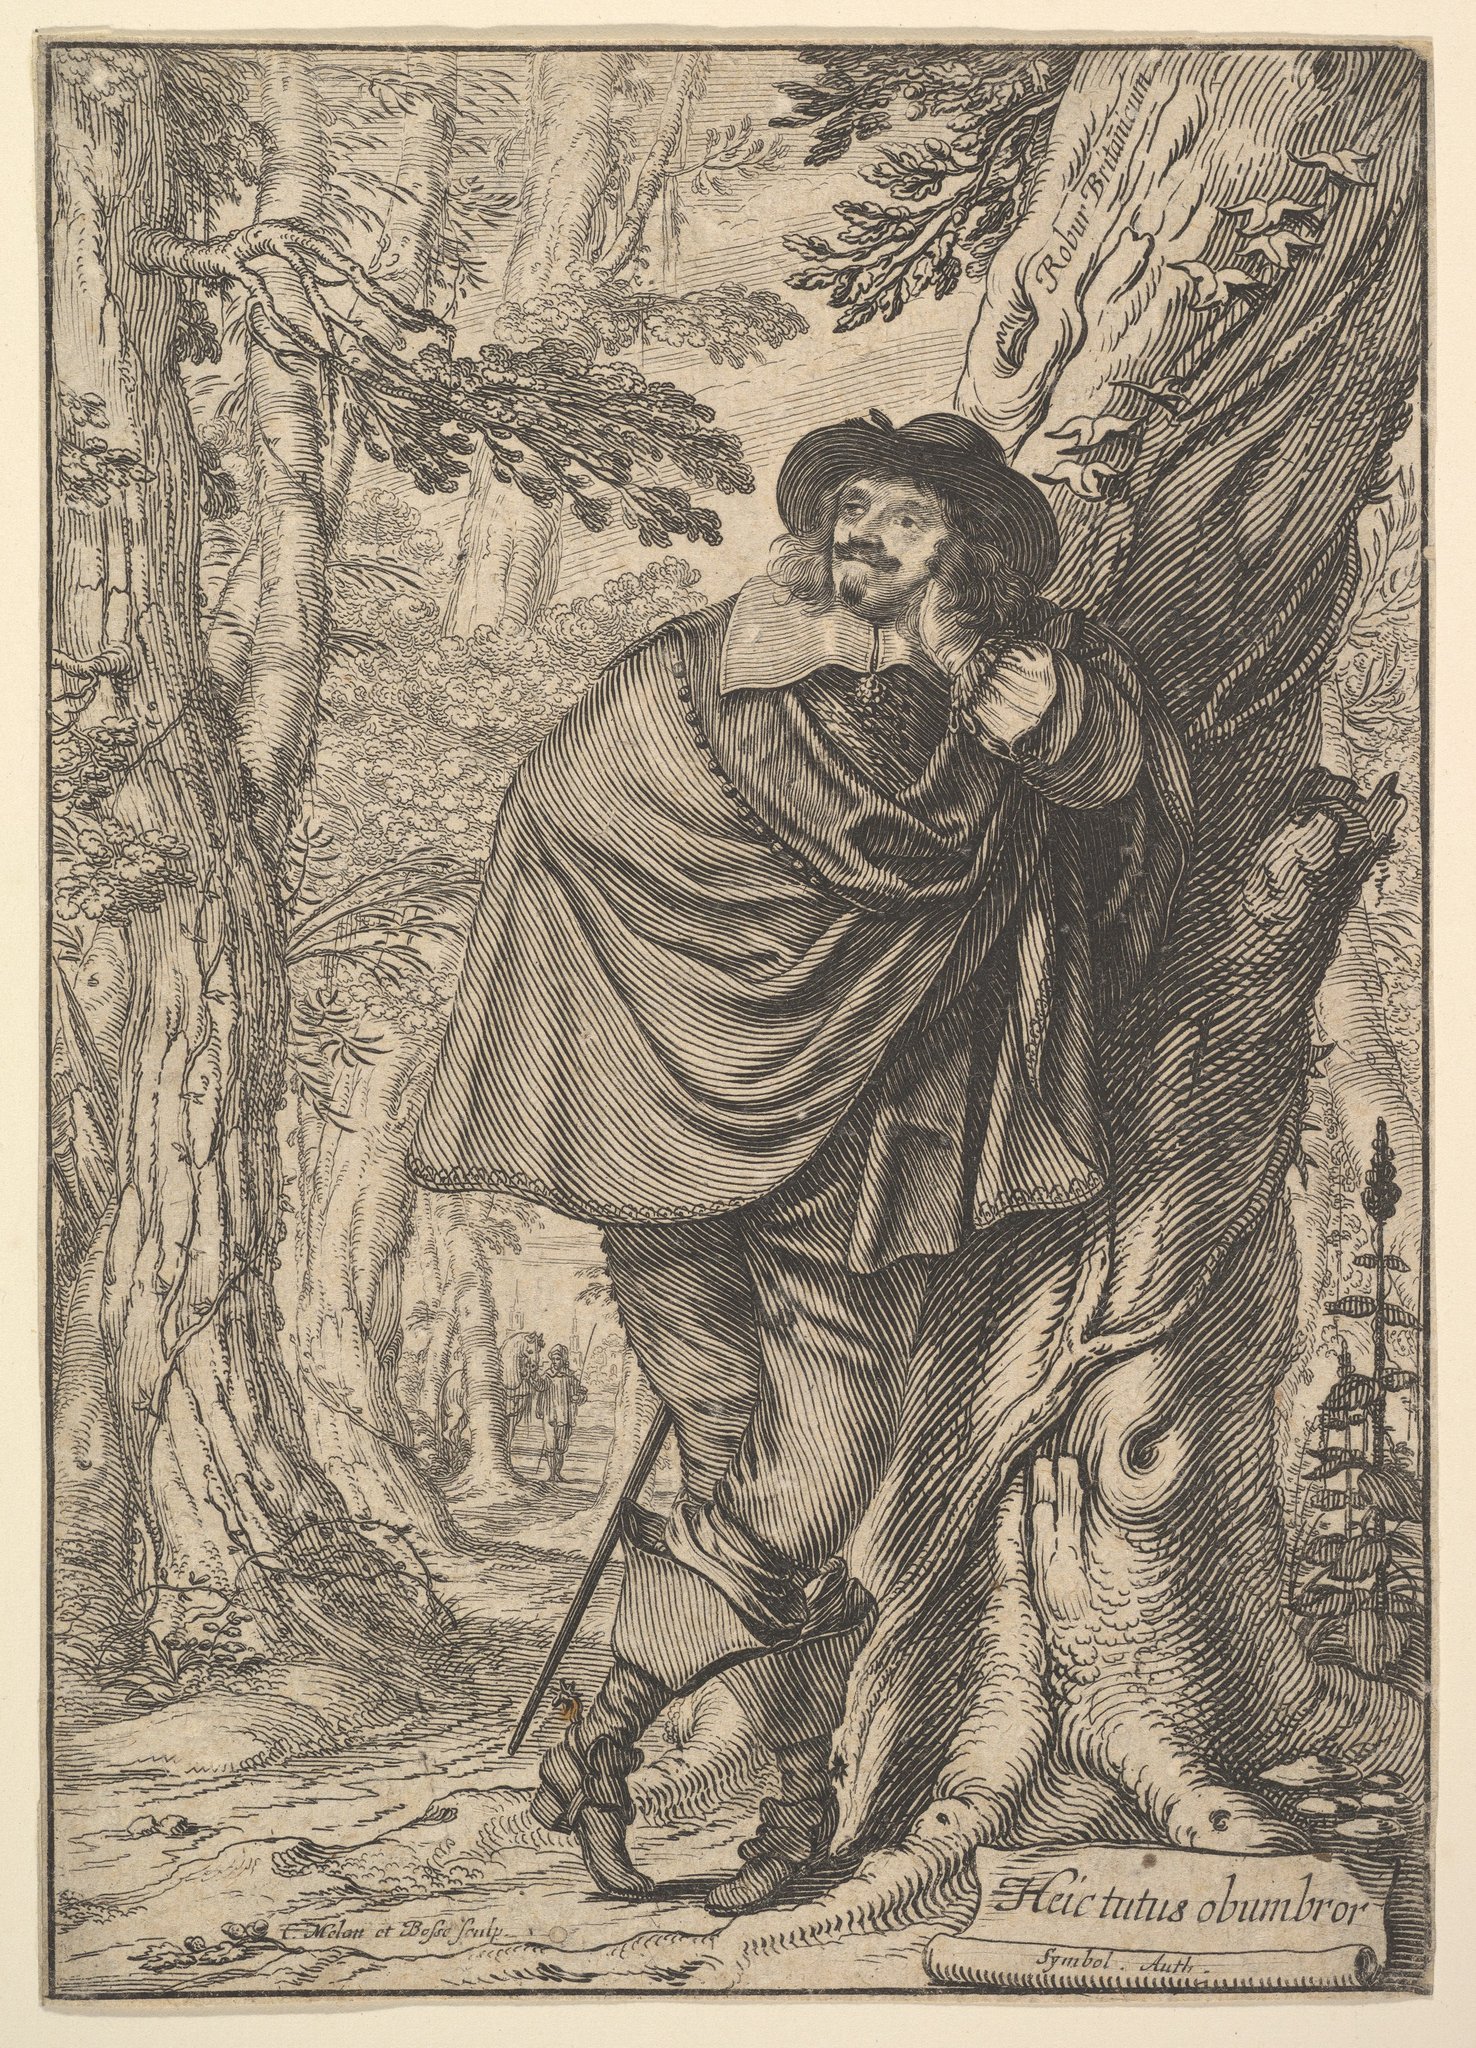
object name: print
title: James Howel Standing in a Forest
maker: claude mellan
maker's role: artist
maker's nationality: french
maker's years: 1598-1688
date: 1641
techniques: engraving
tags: men,forests